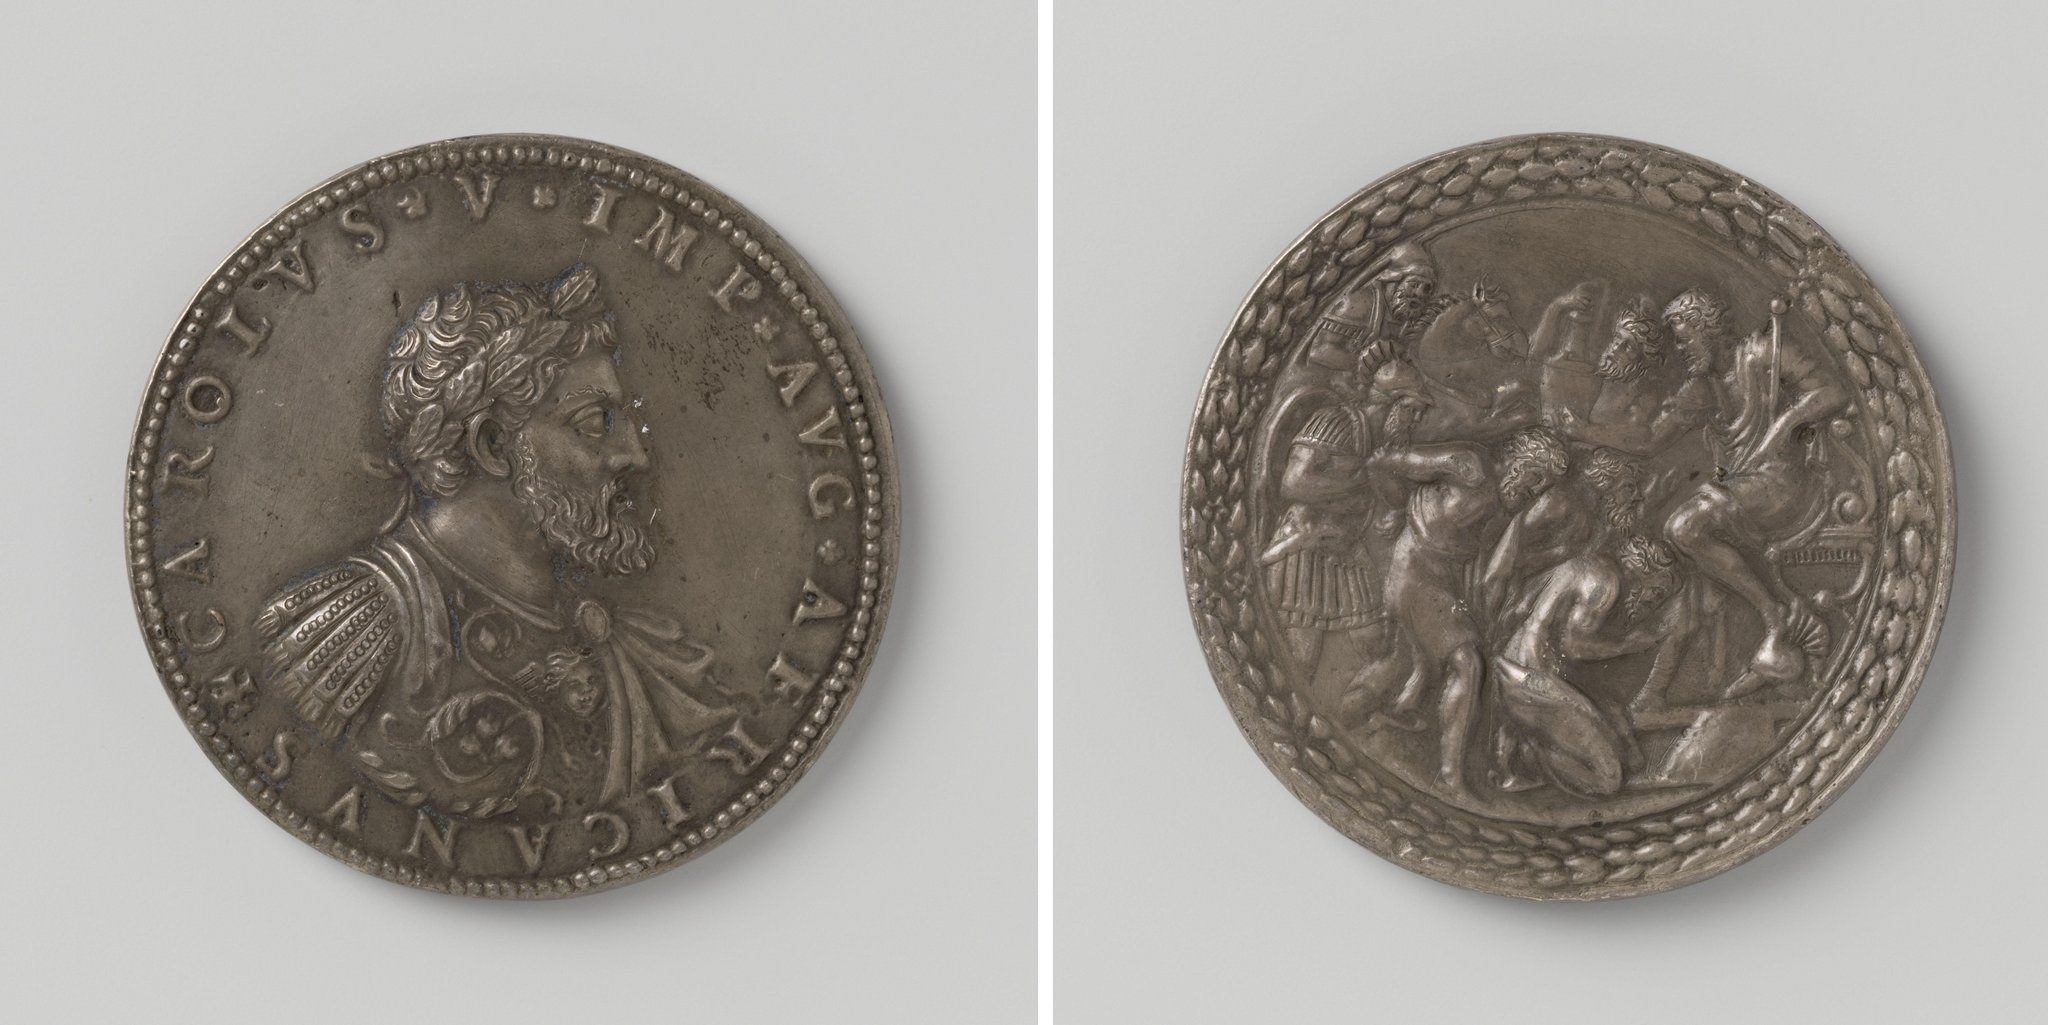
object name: history medal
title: Karel V neemt Tunis in en bevrijdt de christenslaven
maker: Anonymous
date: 1535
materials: silver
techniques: striking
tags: ghent, charles v (holy roman emperor and king of spain), slavery; serfs and enslaved persons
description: Zilveren penning. Voorzijde: borststuk man met lauwerkrans binnen omschrift. Keerzijde: bevrijde krijgsgevangenen bedanken Scipio, terwijl soldaten buit maken binnen lauwerkrans